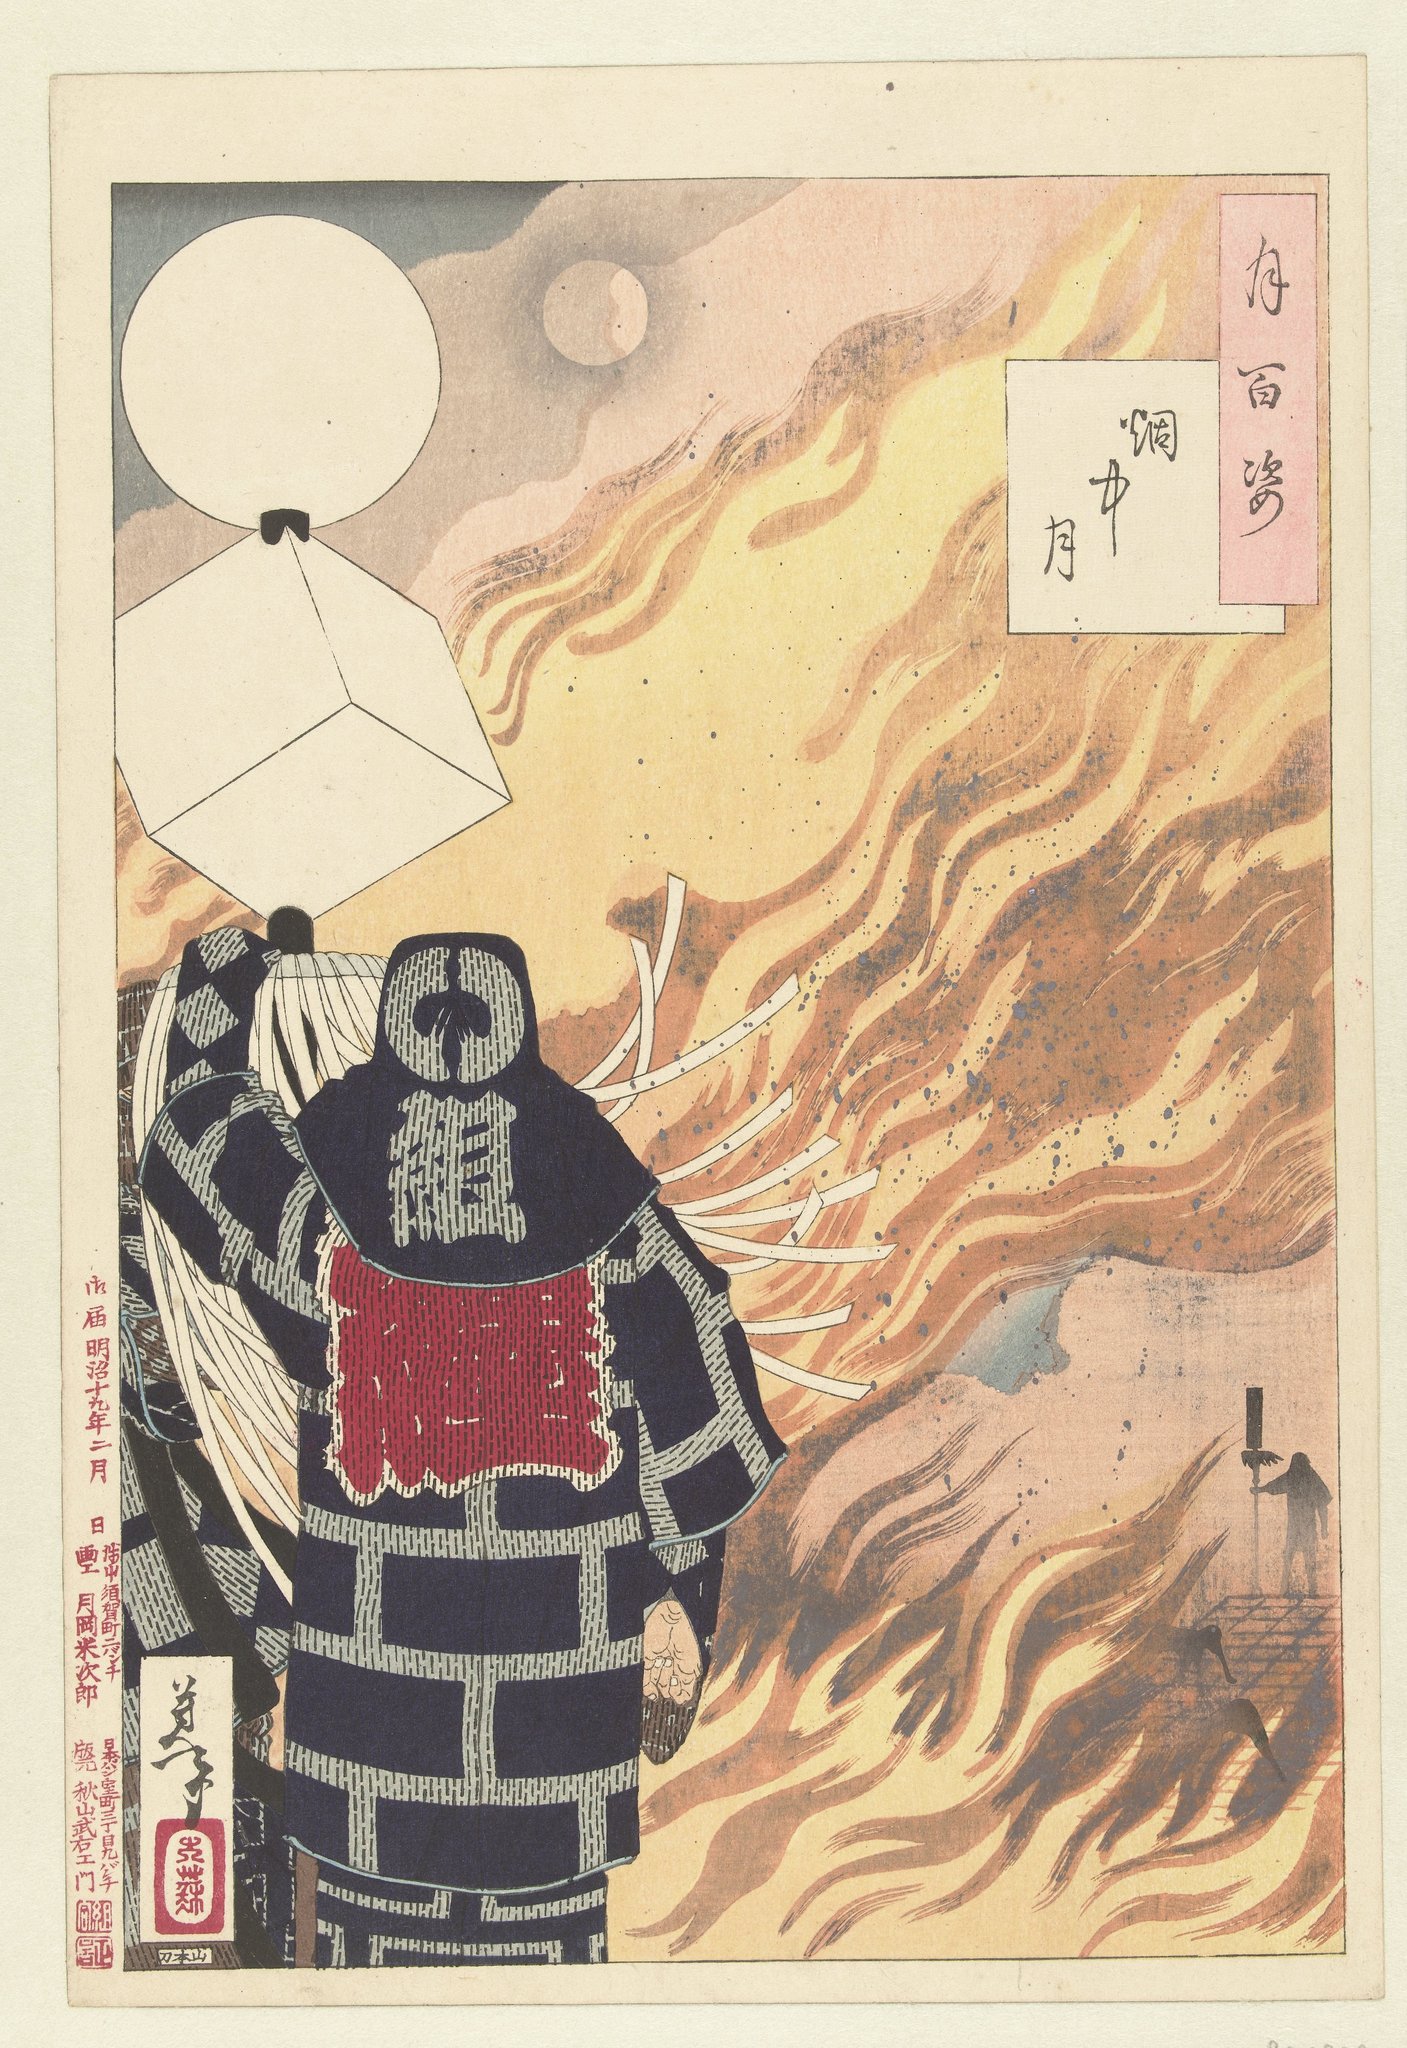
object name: print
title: Honderd aspecten van de maan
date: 1802-1886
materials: paper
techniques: blind stamped, woodcut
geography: japan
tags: standing figure, fire-fighting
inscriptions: collector's mark: Lugt 2228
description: Brandweerman met vaandel, staand bij felle brand; op de achtergrond het silhouet van een tweede brandweerman met vaandel, staand op de nok van een huis waarvan twee mannen de dakbedekking verwijderen, om verspreiding van het vuur tegen te gaan.